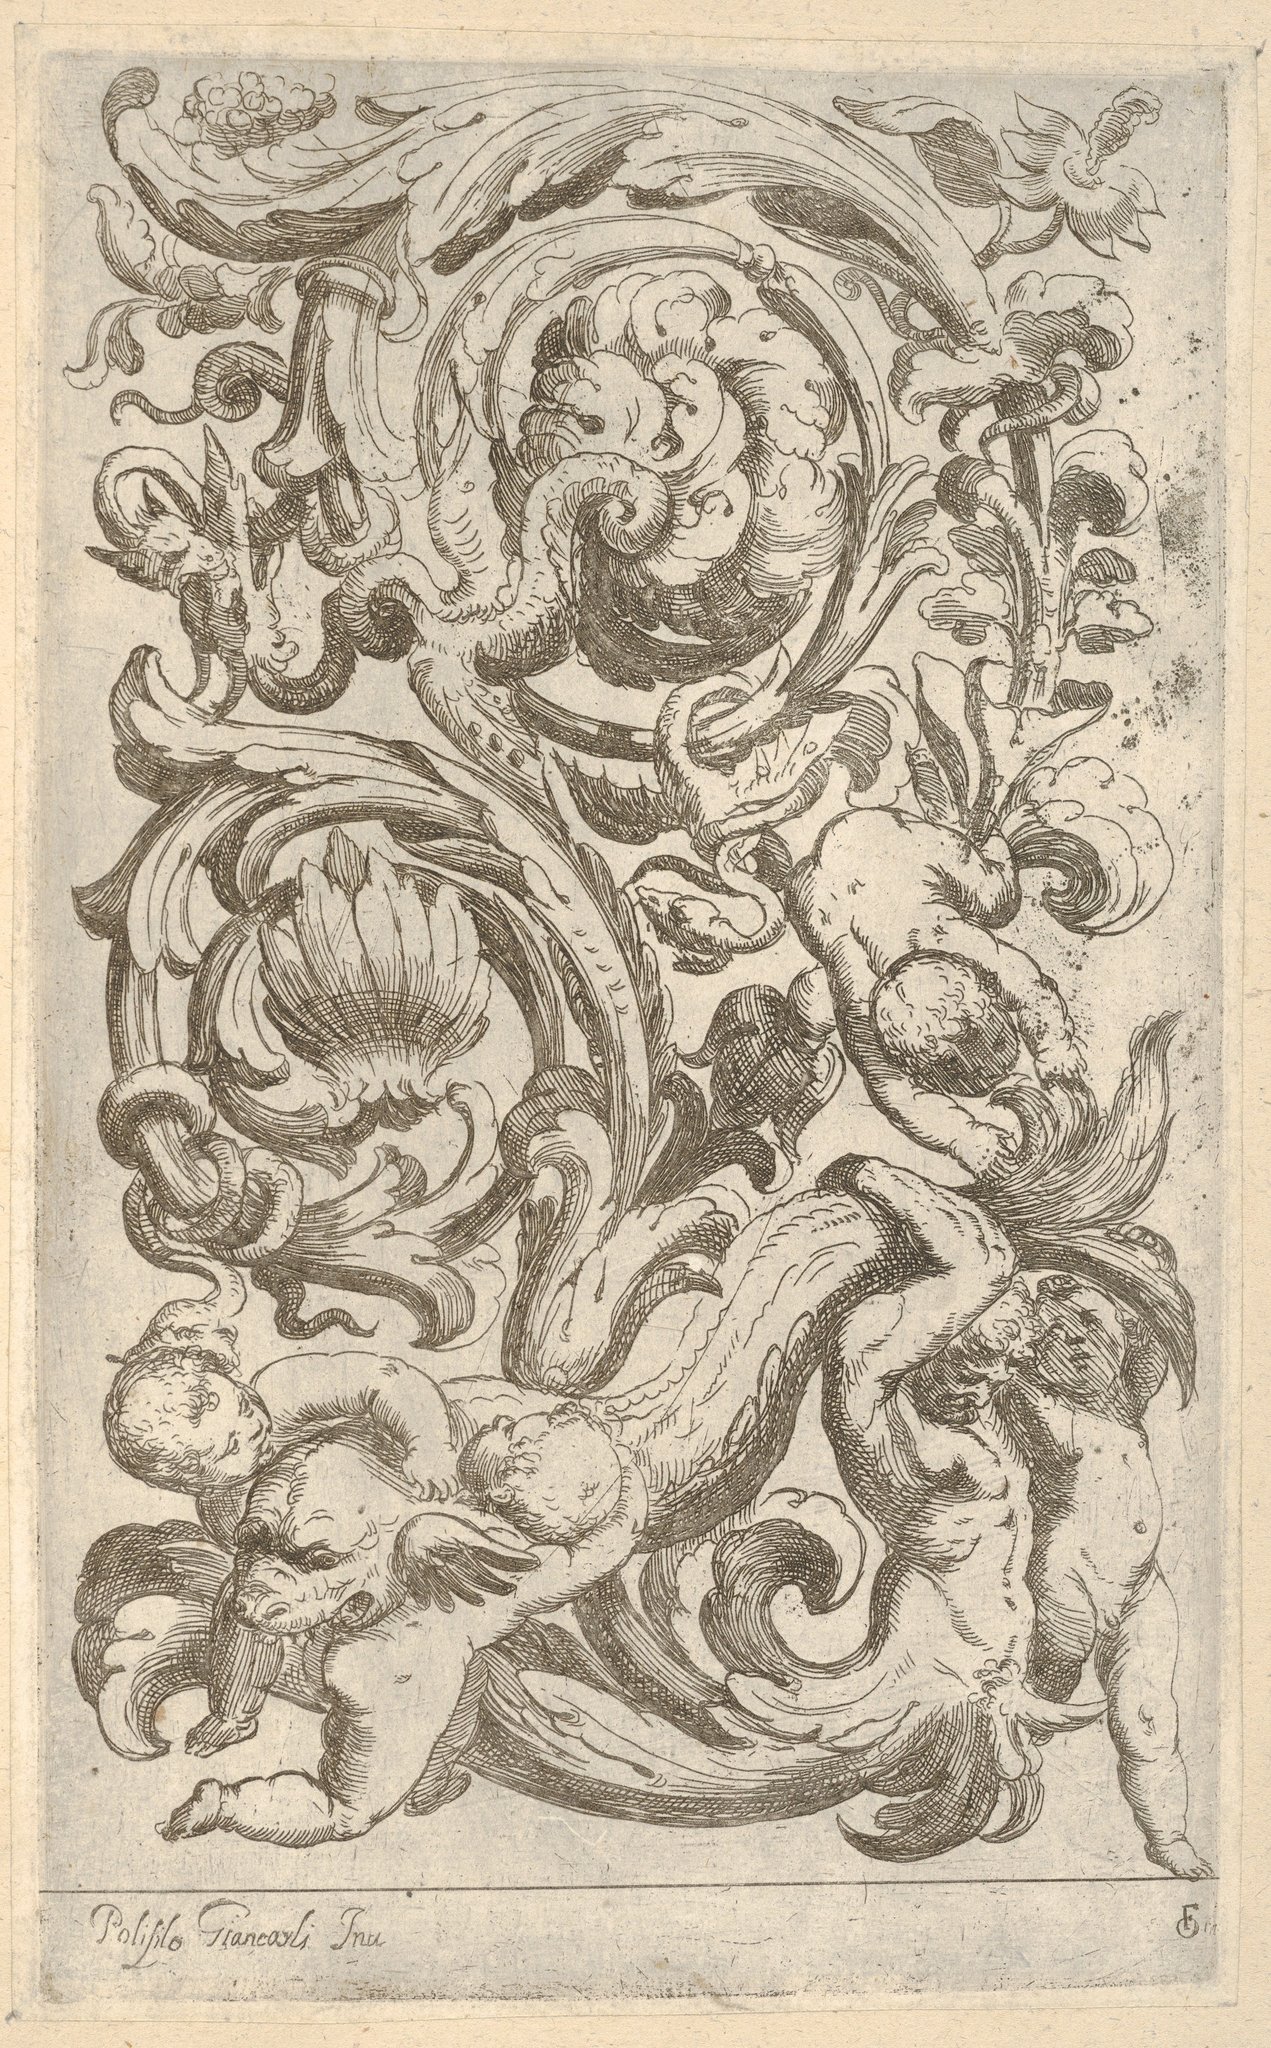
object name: collection ornament architecture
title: Disegni Varii di Polifilo Zancarli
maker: polifilo giancarli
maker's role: artist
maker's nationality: italian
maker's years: 1600-1625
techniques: etching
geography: italy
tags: mythical creatures,putti,acanthus